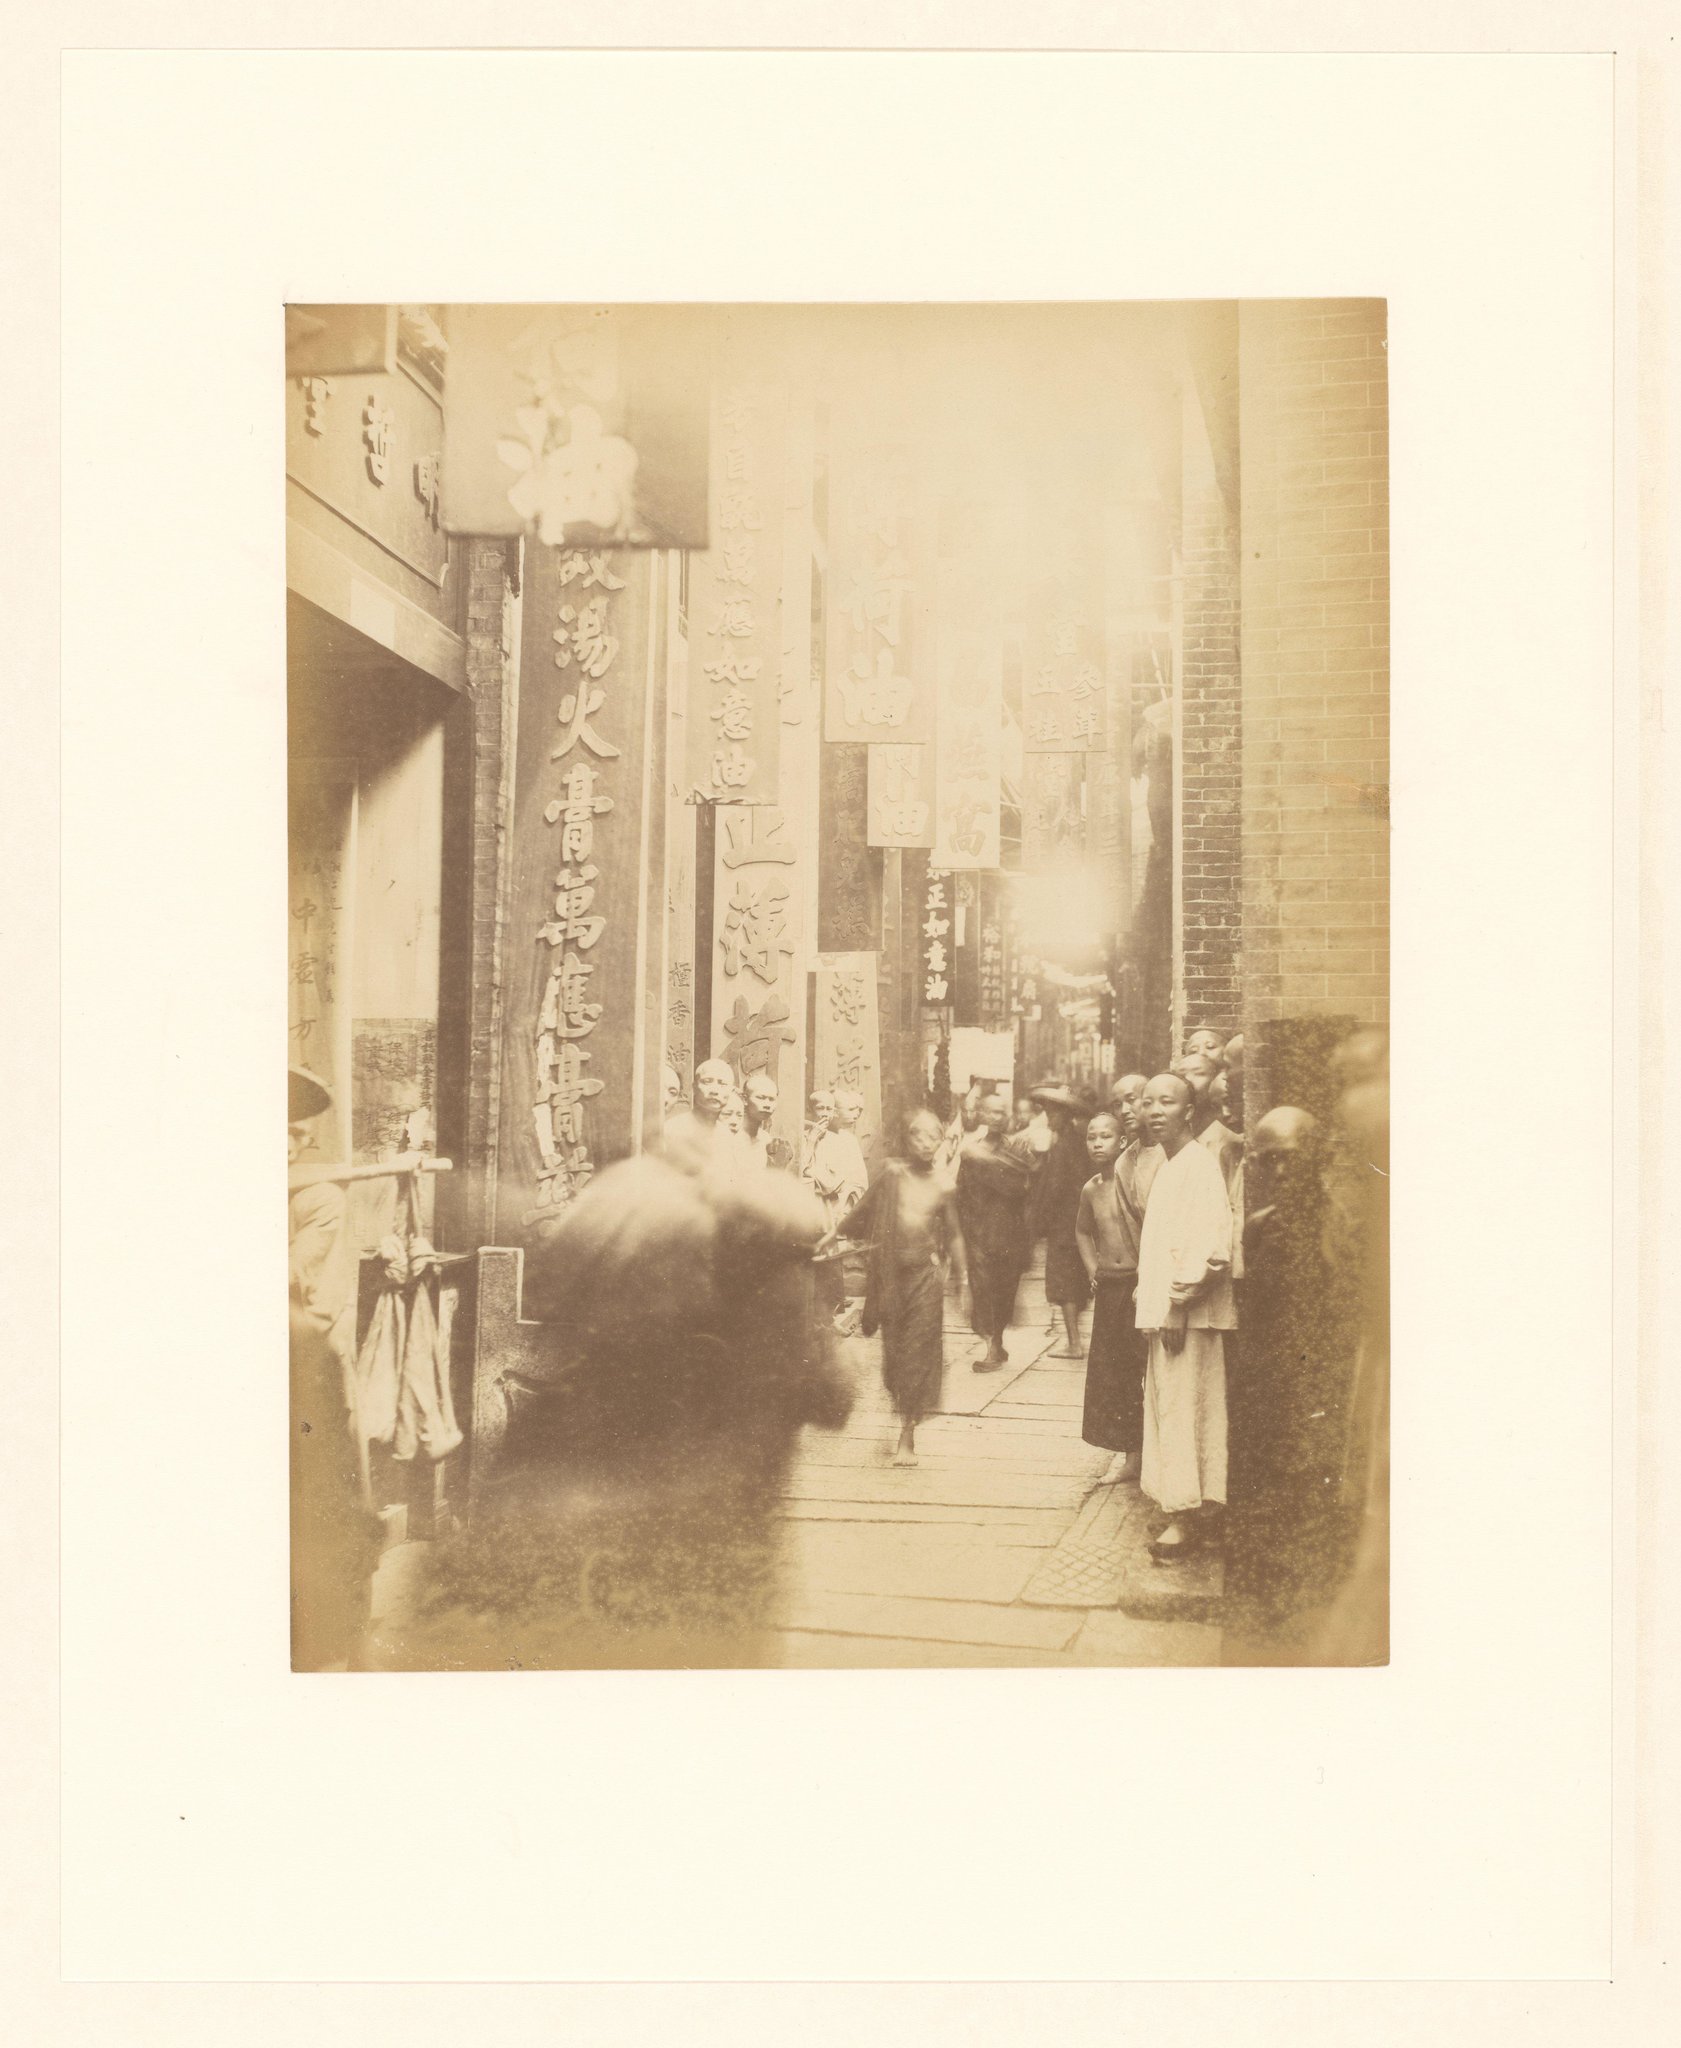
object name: photograph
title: Straatgezicht met uithangborden te China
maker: Anonymous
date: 1860-1900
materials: cardboard, photographic support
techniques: albumen print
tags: street (+ city(-scape) with figures, staffage)